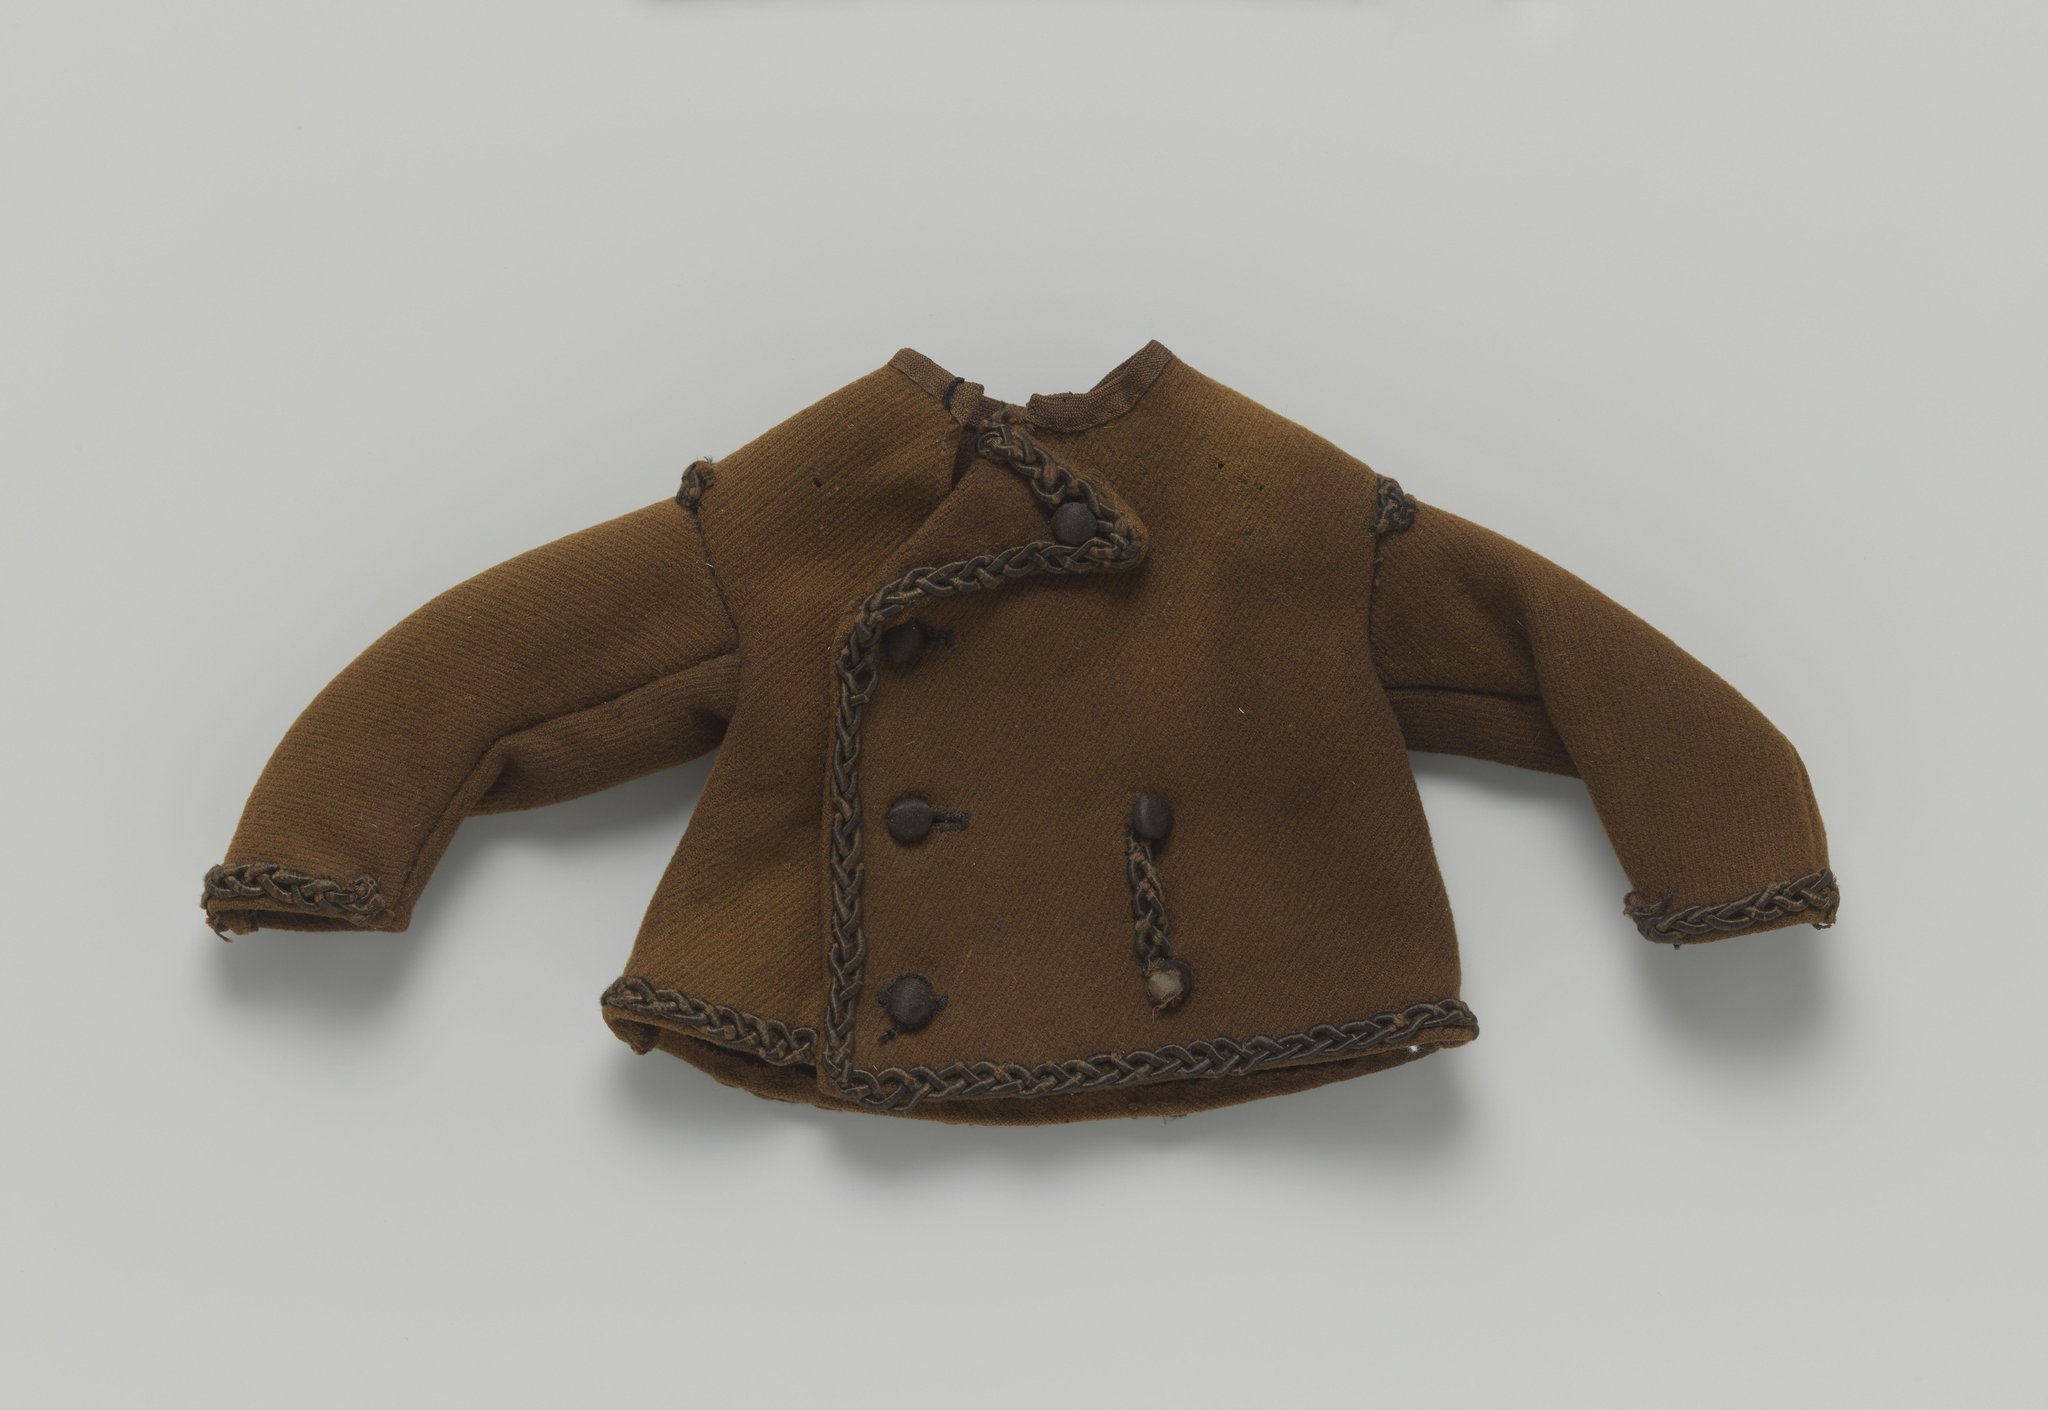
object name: doll's clothing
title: Jas, bruin, afgewerkt met gevlochten soutache.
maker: Anonymous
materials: cotton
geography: netherlands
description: Rok van bruine wol, met bruine gevlochten soutache afgebiesd.